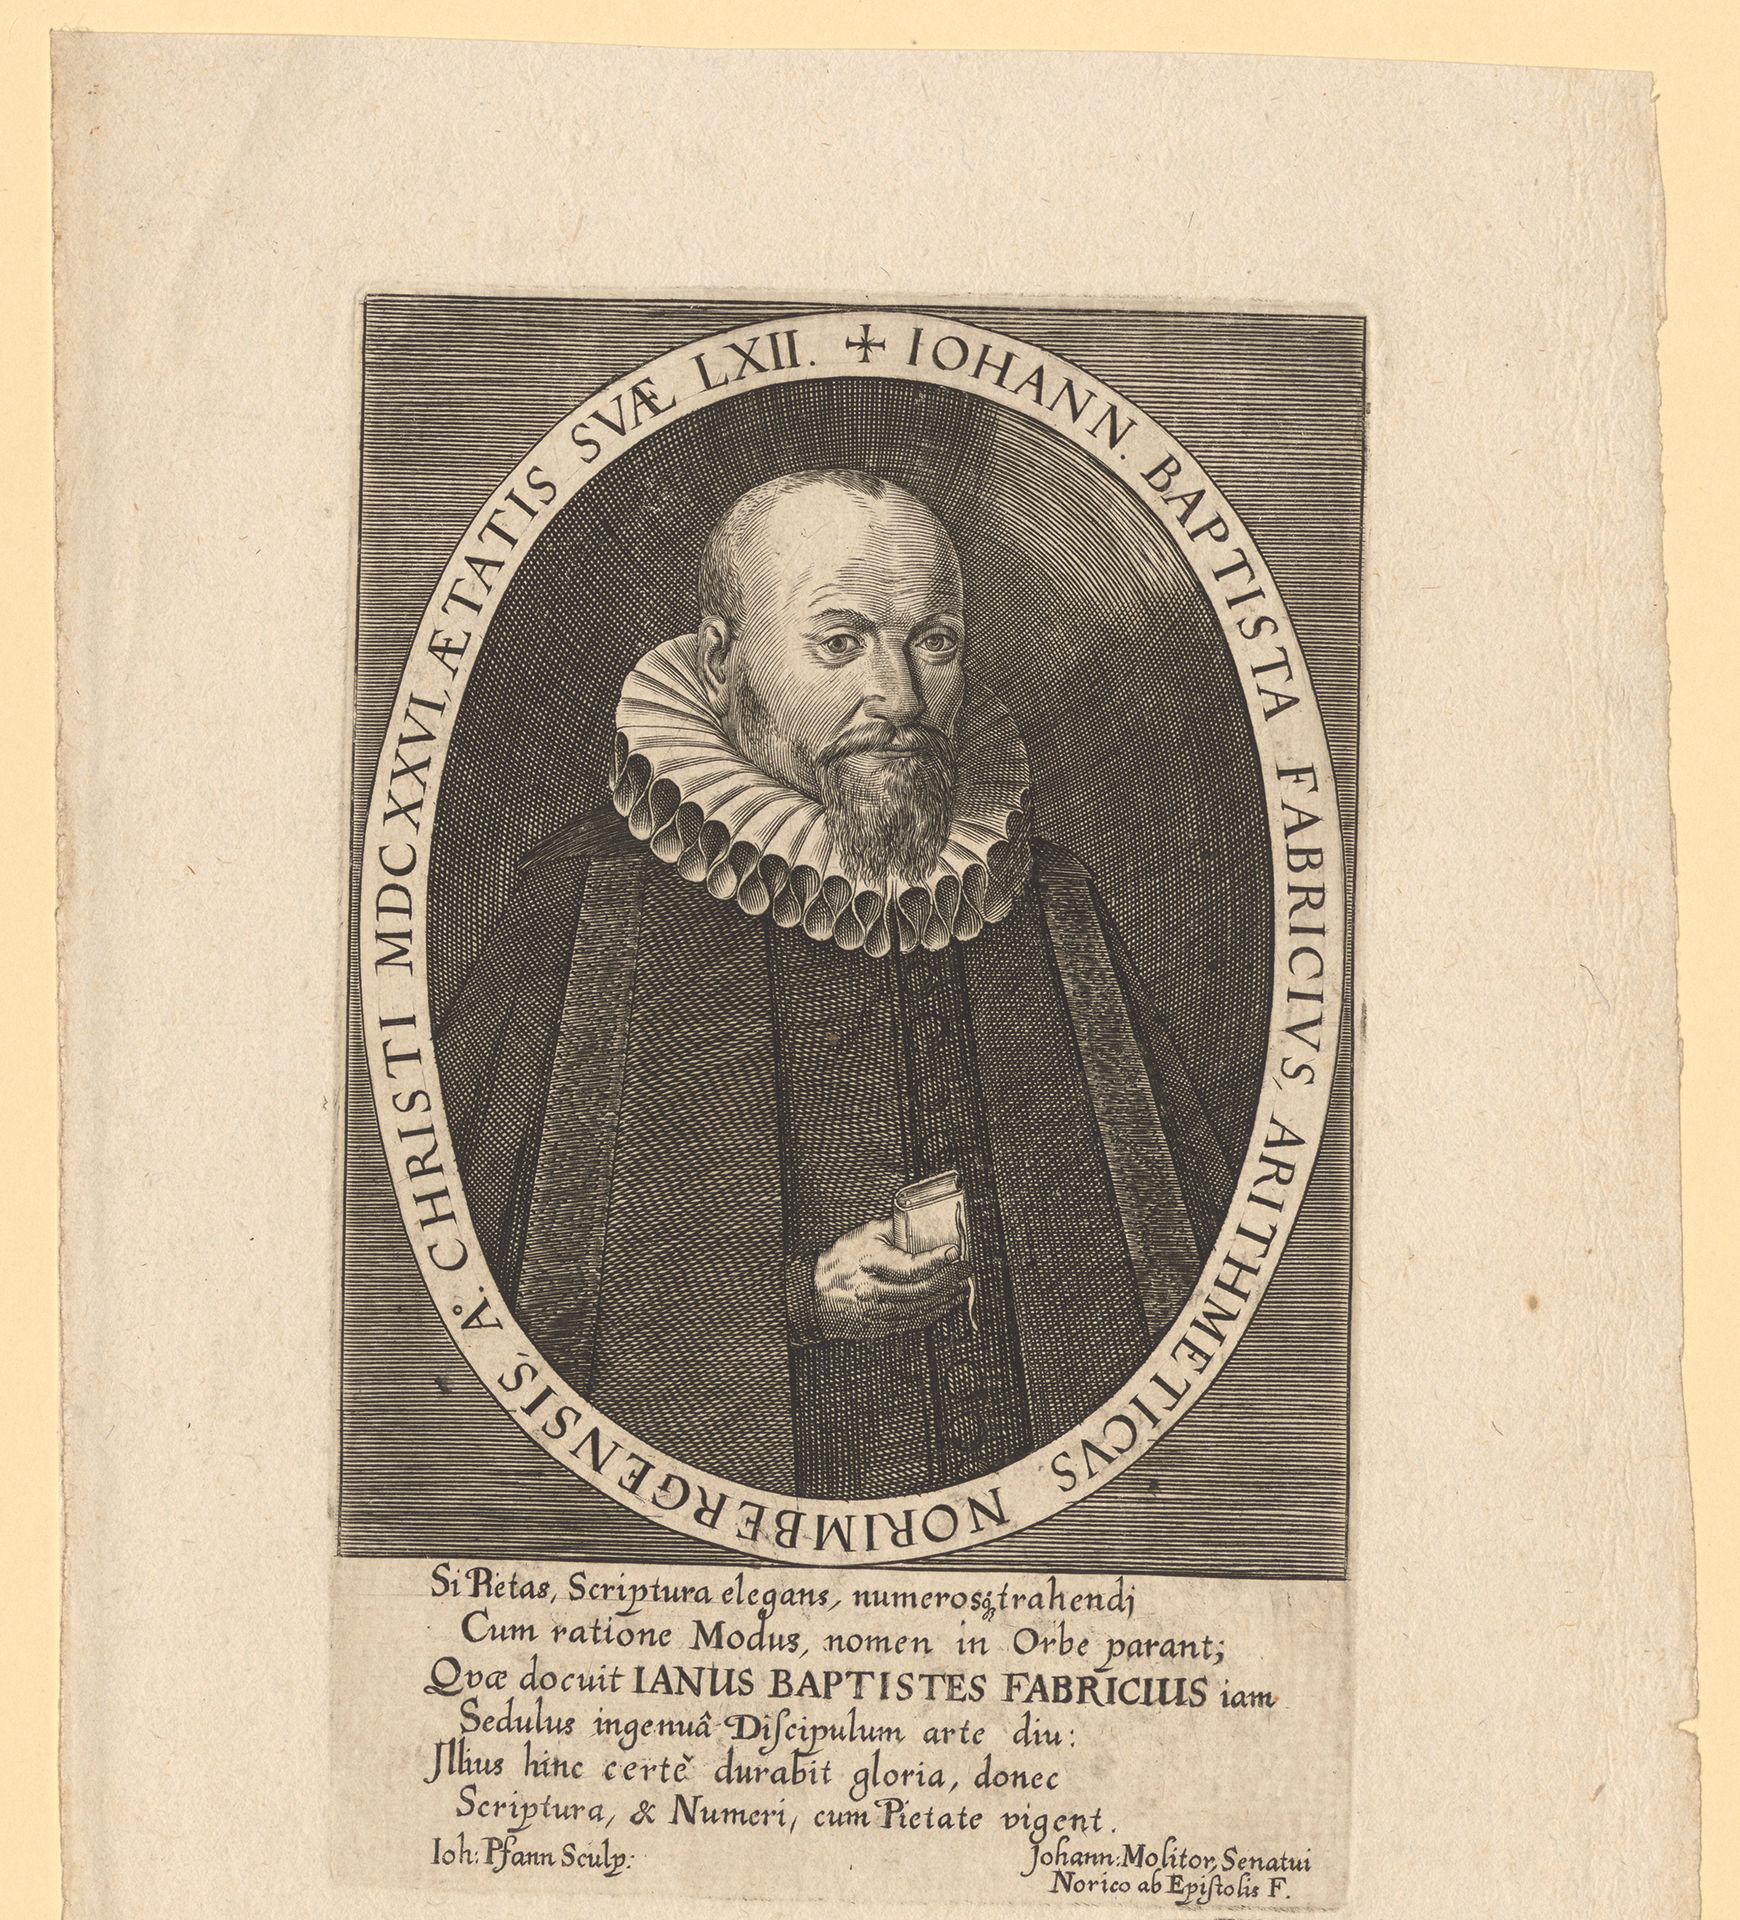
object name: print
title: Portret van Johann Baptist Fabricius op 62-jarige leeftijd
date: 1648-1663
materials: paper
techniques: engraving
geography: germany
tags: historical persons, book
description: Met zesregelig vers in het Latijn onder het portret.